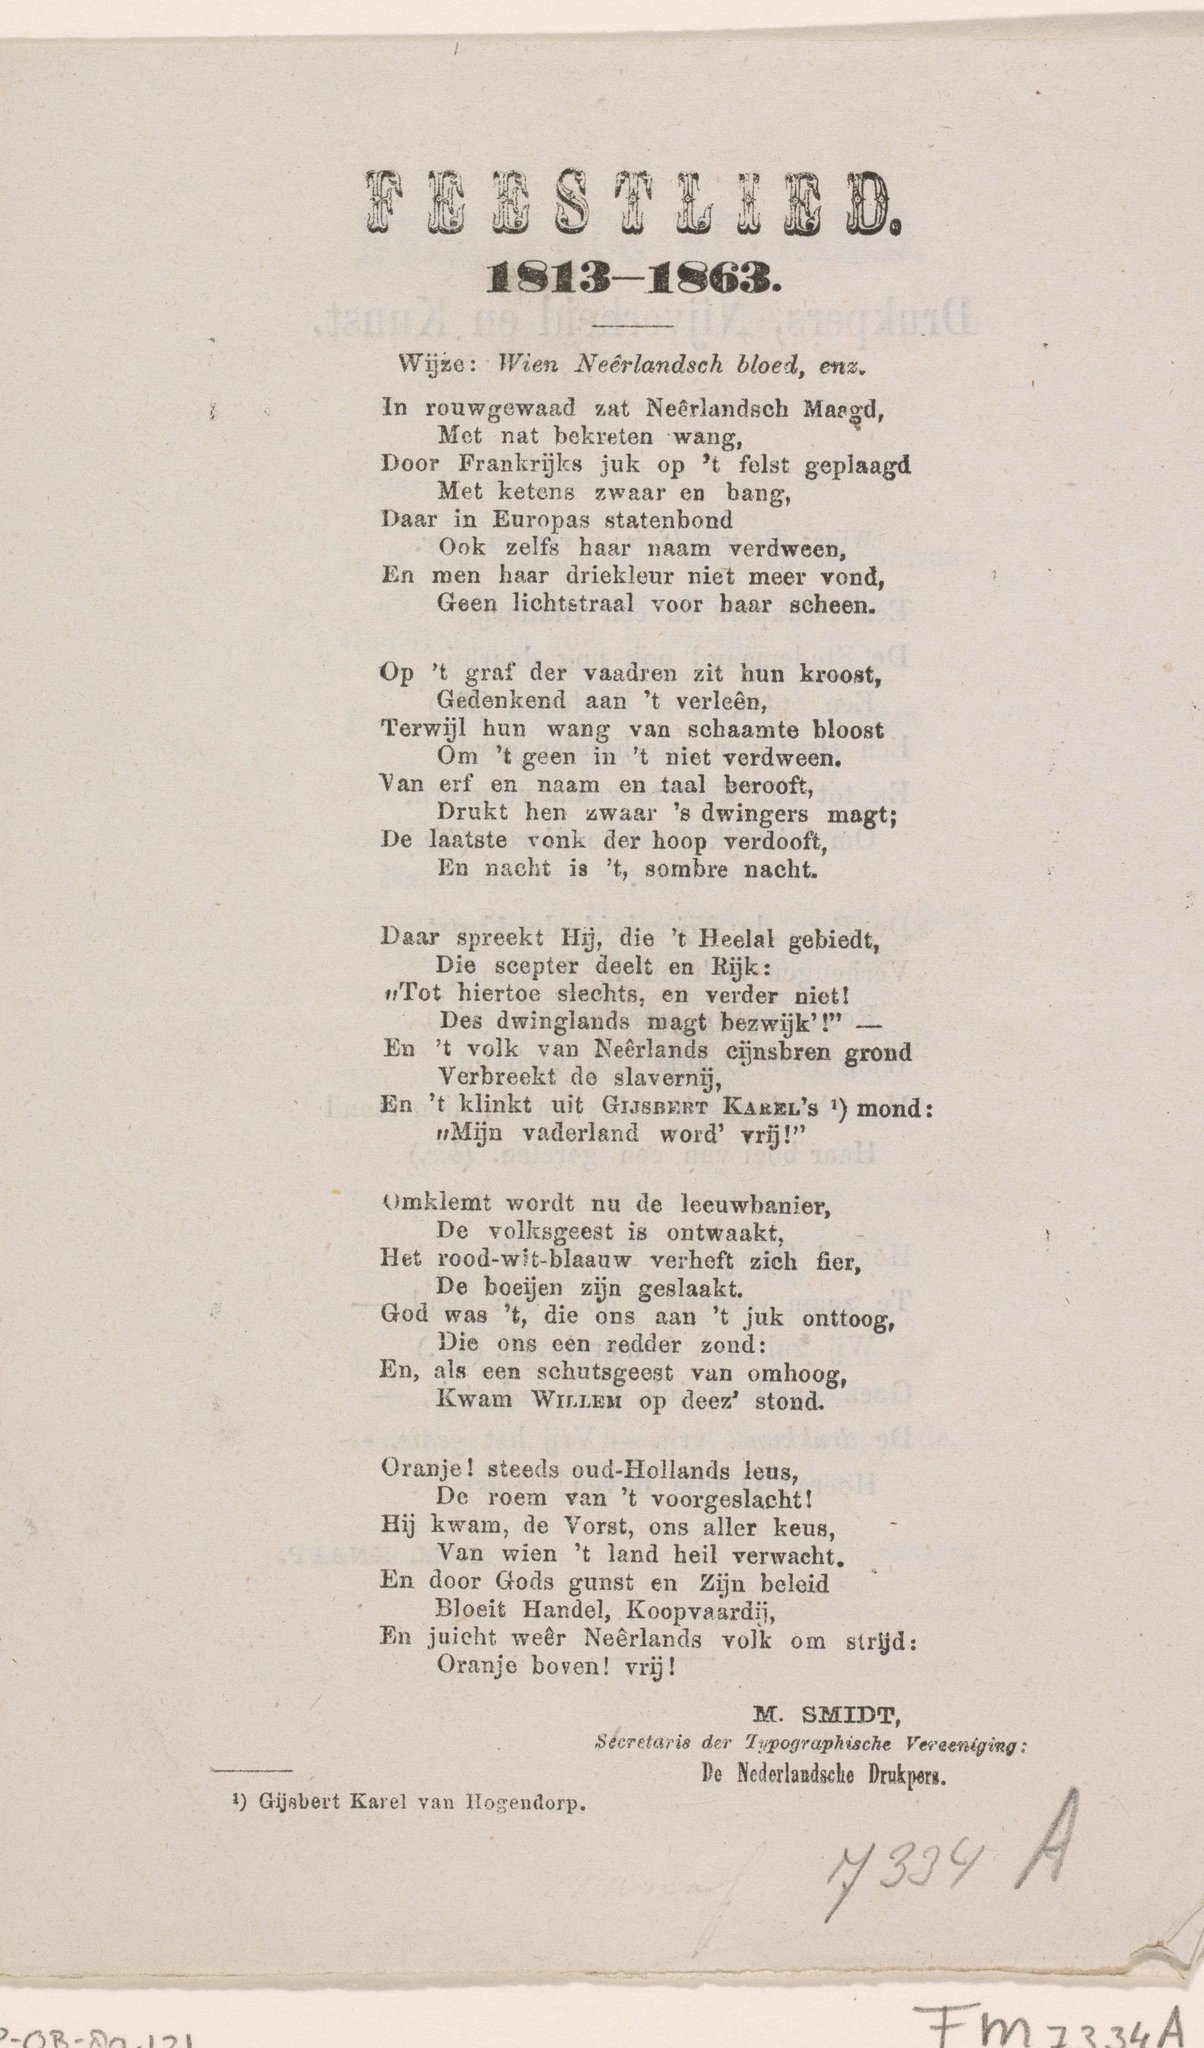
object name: text sheet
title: Feestlied 1813-1863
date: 1863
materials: paper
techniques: letterpress printing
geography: netherlands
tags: vocal popular music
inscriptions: collector's mark: Lugt 2228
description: Blad met feestliederen ter gelegenheid van het vijftigjarige jubileum van het herstel van de vrijheid in Nederland, 16 november 1863. Geheel georganiseerd door de 'Typographische Vereeniging: De Nederlandsche Drukpers'. In vieren gevouwen blad bedrukt op alle acht zijden met de de liederen: Feestlied 1813-1863, De Volksgeest, Oranje Boven!, Hoezee!, Neerlands Vrijheid, '16 November 1863', 'Drukpers, Nijverheid en Kunst' en 'Amsterdam op 16 November 1863'.